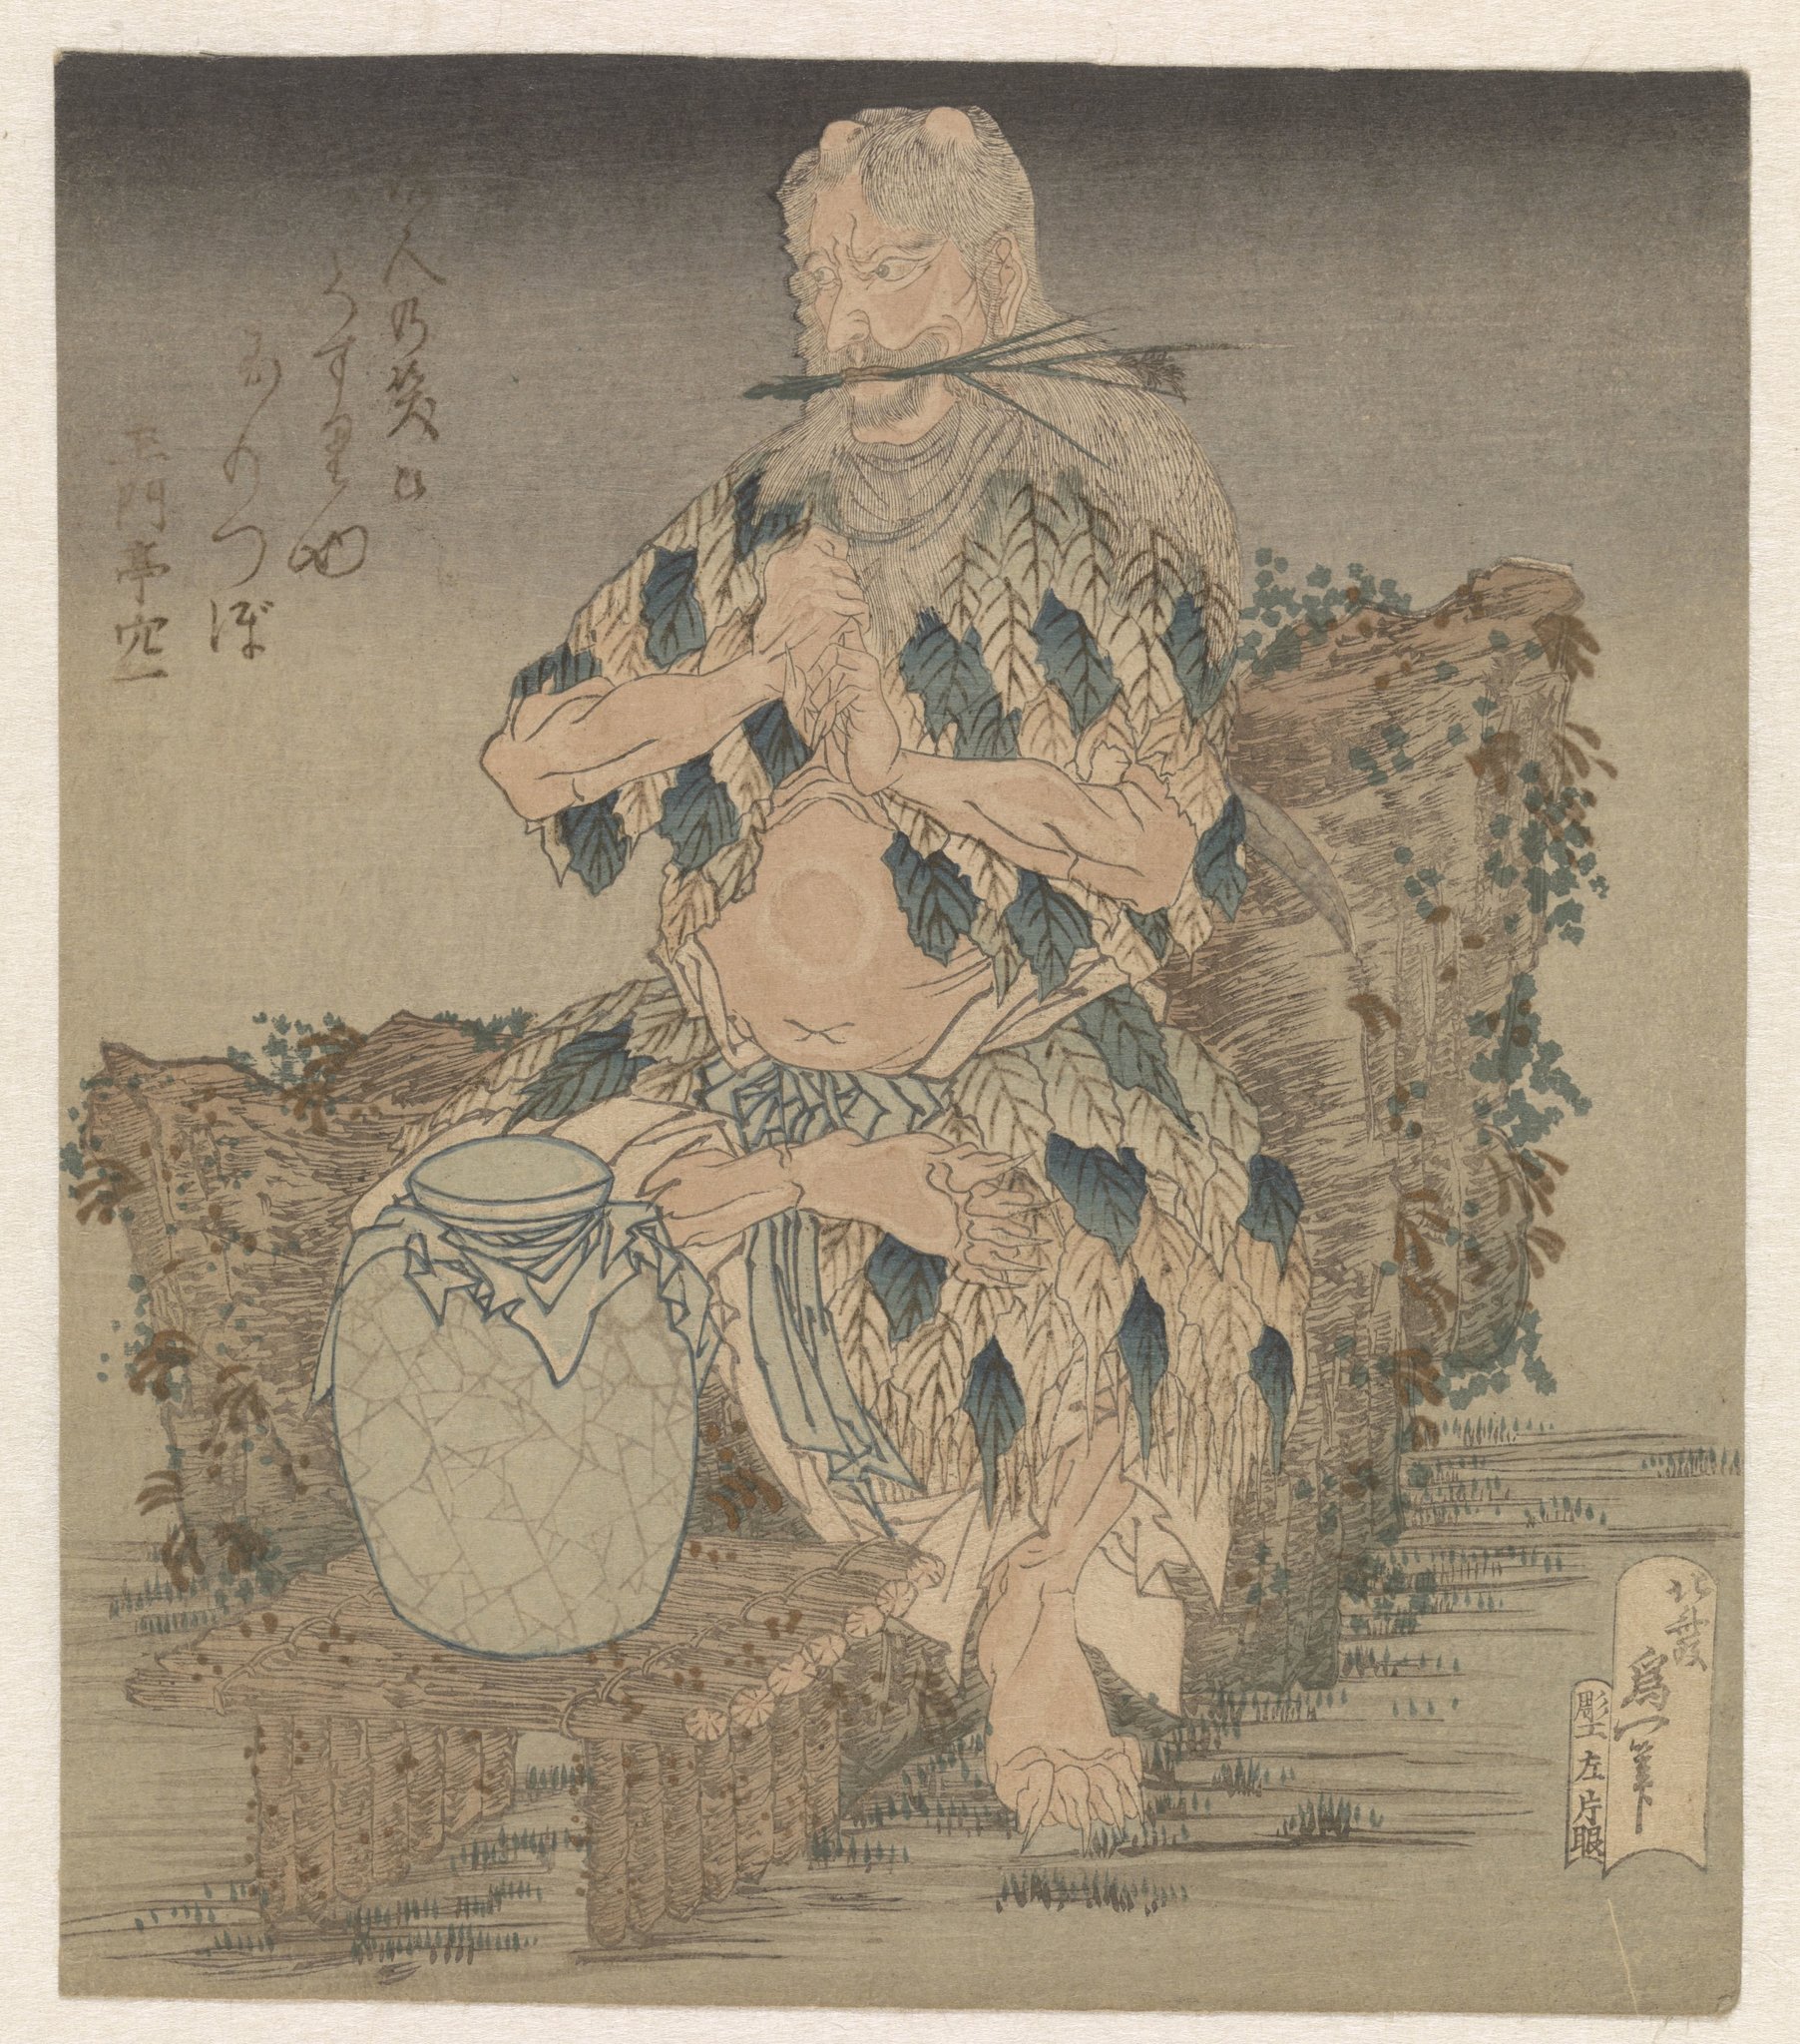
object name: surimono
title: Man in gewaad van bladeren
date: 1890-1900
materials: paper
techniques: blind stamped, woodcut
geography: japan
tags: shinto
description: Een surimono is een luxe uitgevoerde prent waarop beeld met één of meerdere gedichten gecombineerd is. Bij het drukken van een surimono werd vaak gebruik gemaakt van dikker papier, blinddruk en metaal pigmenten, zoals koper- en zilverpoeder. De prenten werden vaak in opdracht van dichters gemaakt en als exclusief geschenk aan vrienden en relaties gegeven.